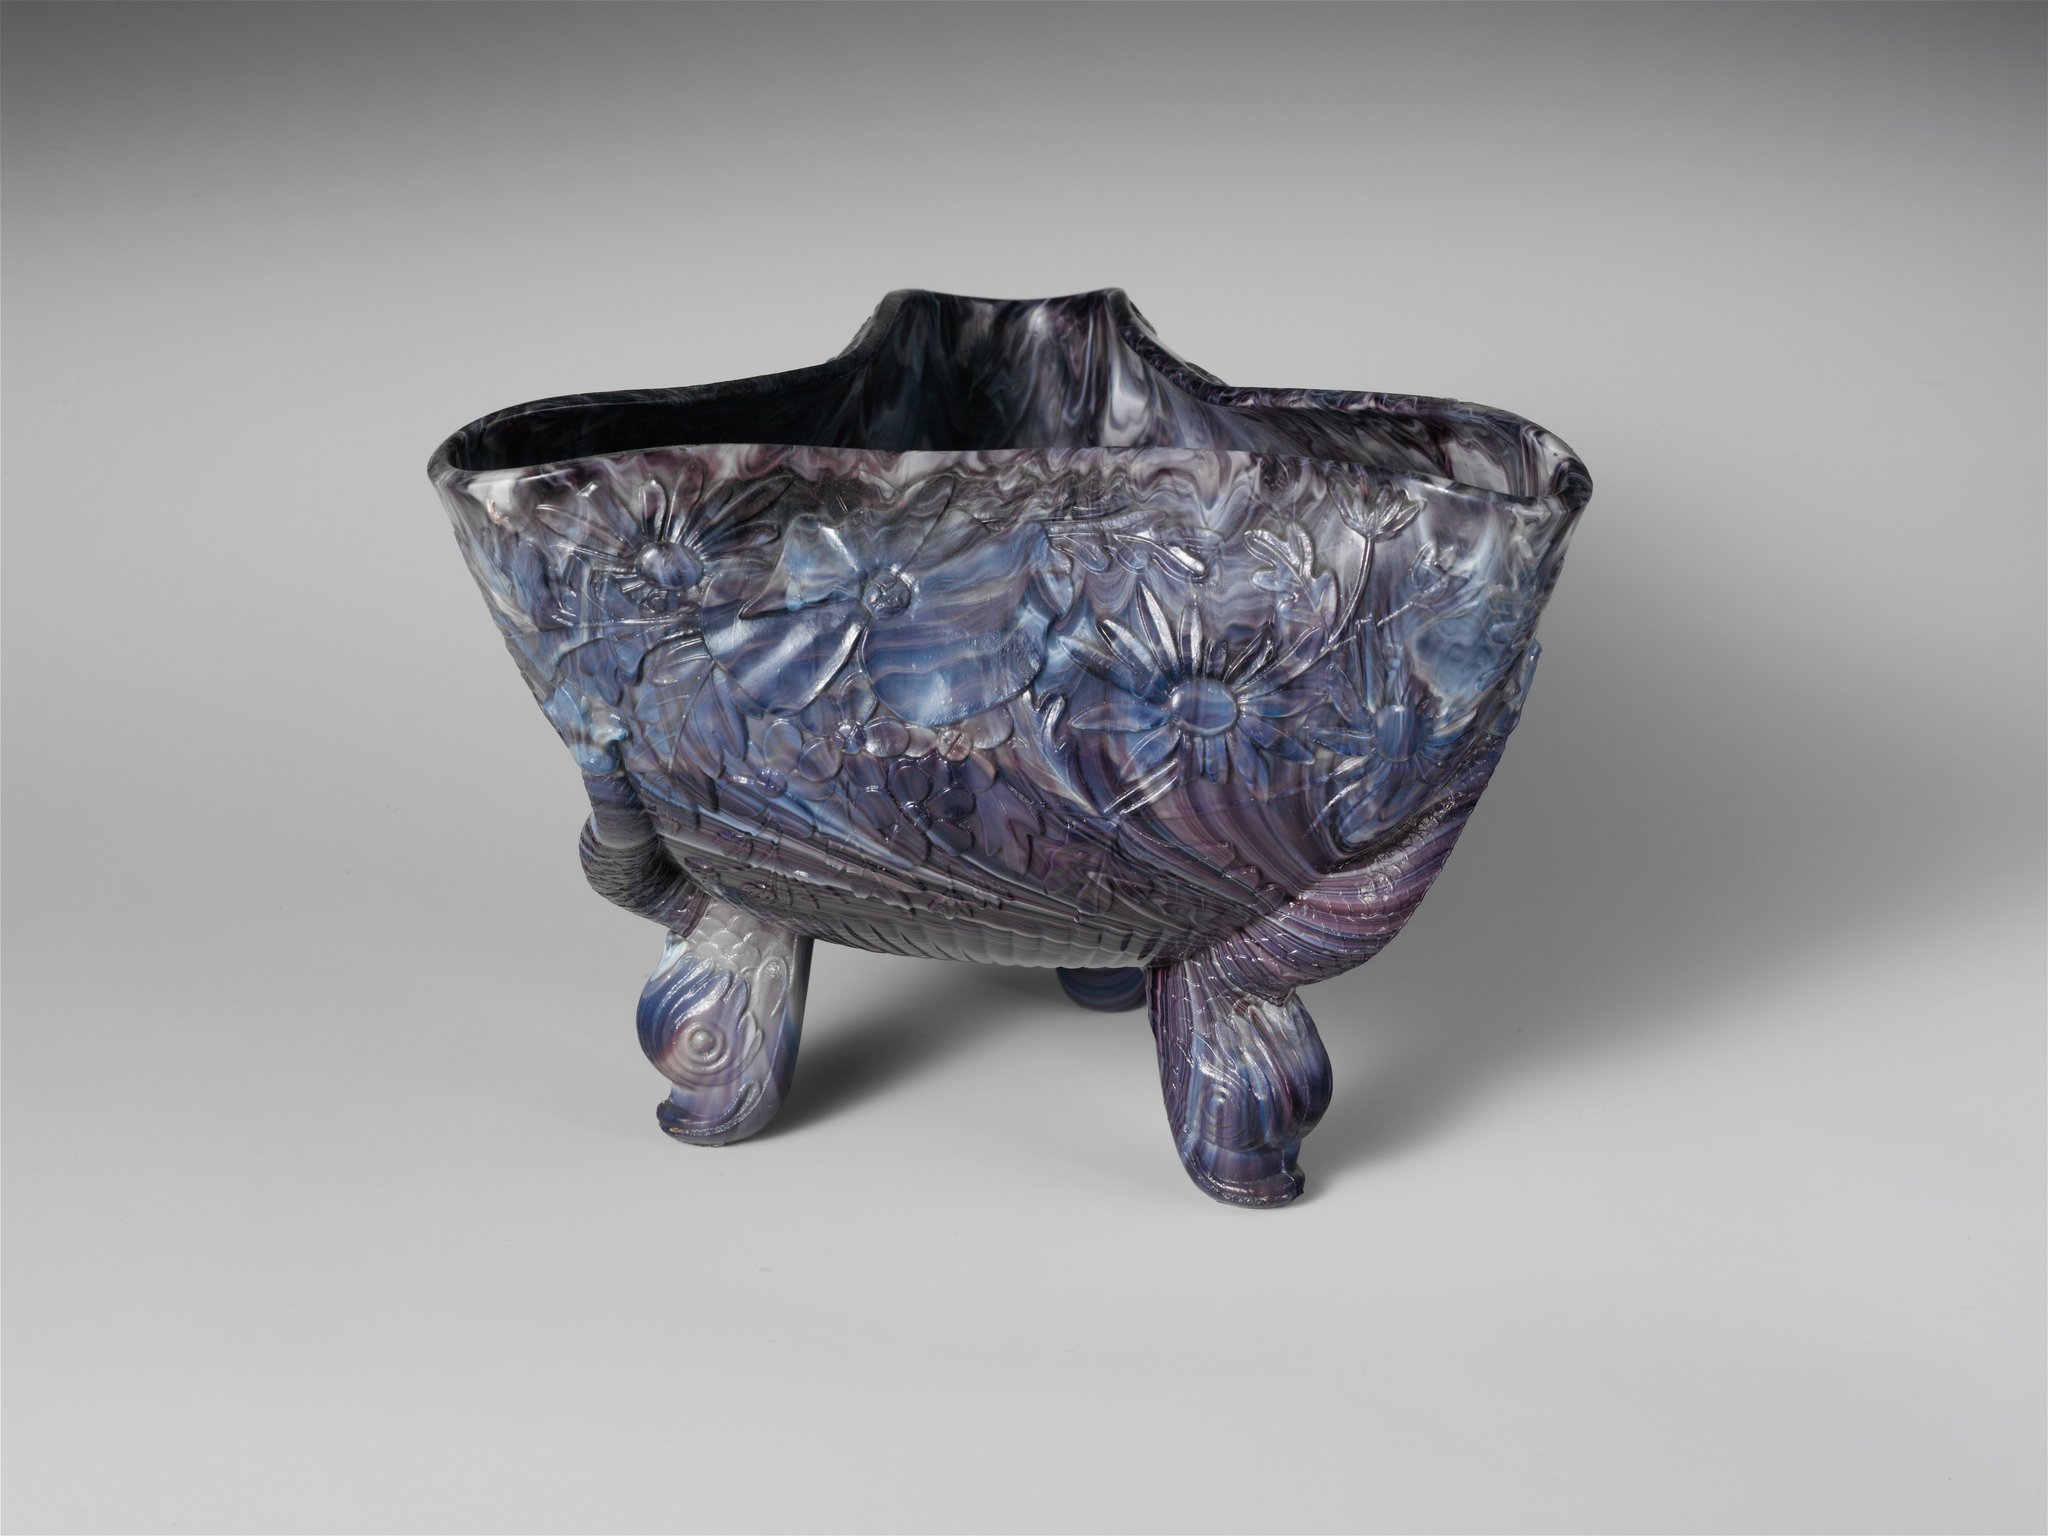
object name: bowl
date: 1880-1890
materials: glass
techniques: pressed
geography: england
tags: flowers